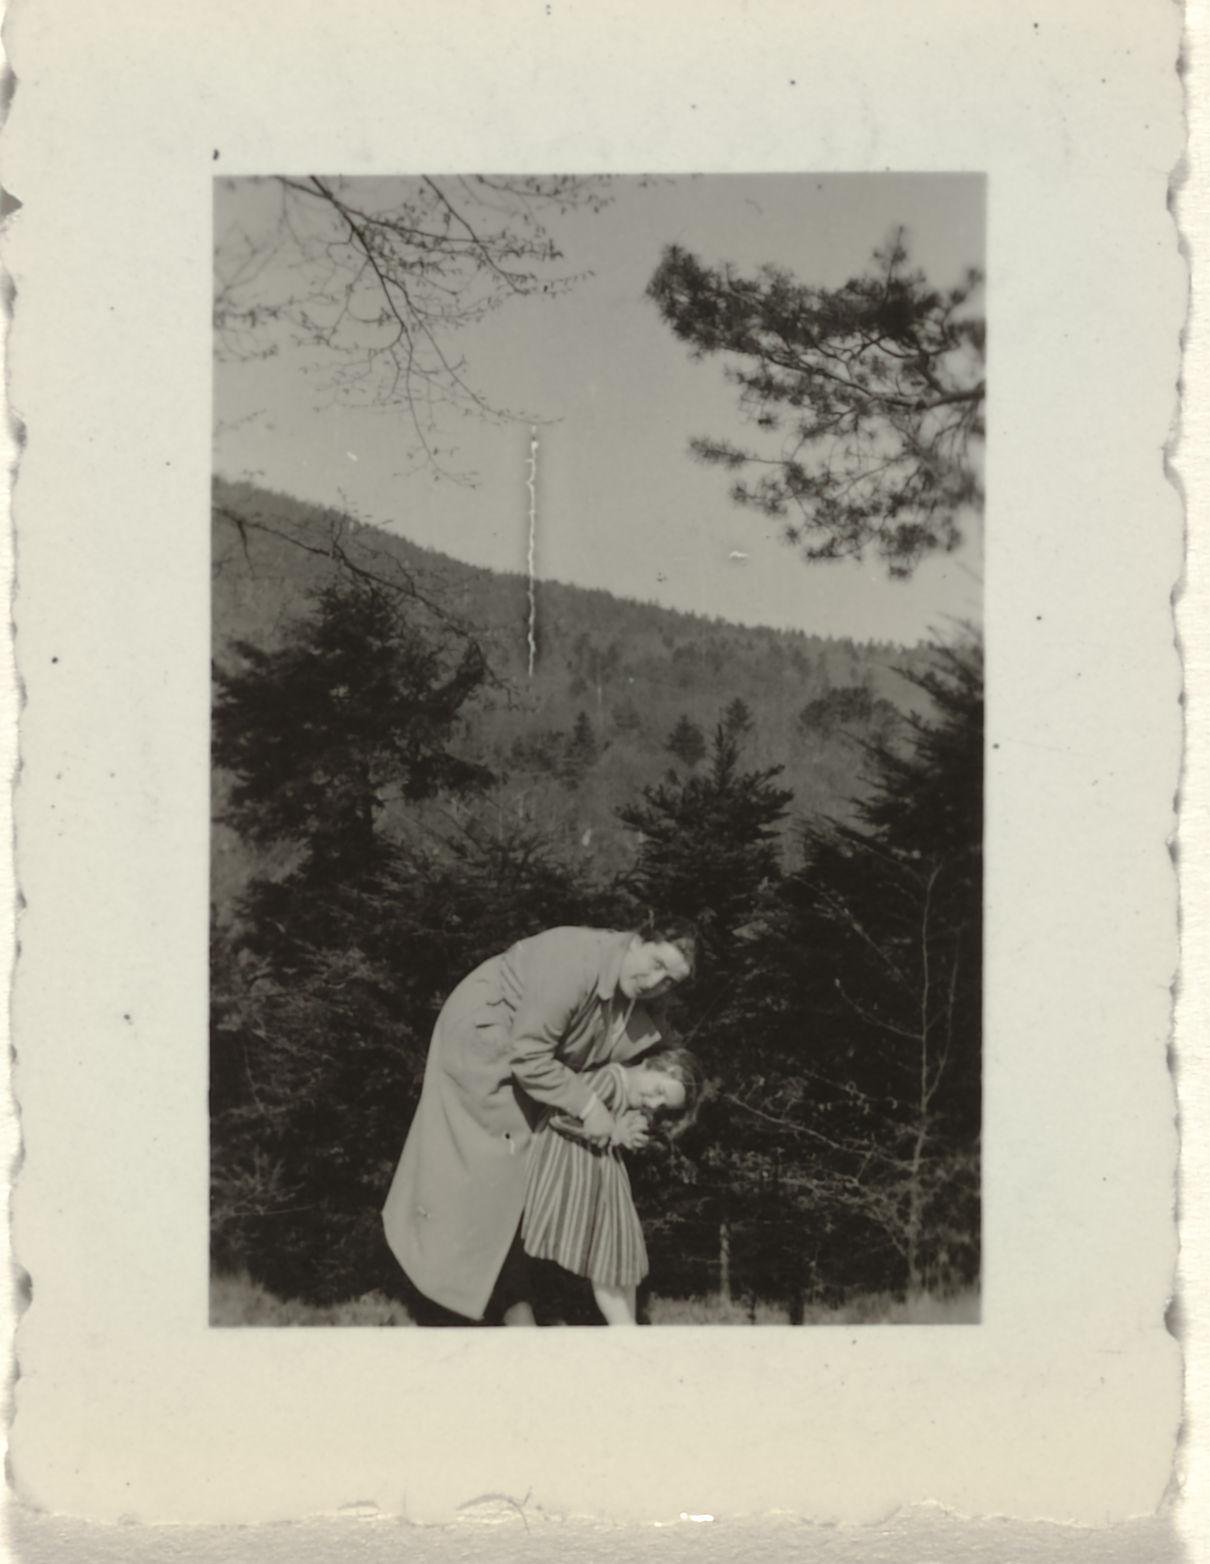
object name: photograph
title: Knuffelende Else Wachenheimer en Isabel Wachenheimer in de bergen bij Baden-Baden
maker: Anonymous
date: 1932-1937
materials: photographic support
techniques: gelatin silver print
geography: baden-baden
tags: else wachenheimer-moos, leiden, isabel wachenheimer-elon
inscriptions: inscription: ‘Vielleicht last Du es nicht [...] in Baden-Baden’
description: Rechts op de foto staat Isabel Wachenheimer afgebeeld, over haar heen gebogen staat haar moeder Else Wachenheimer.